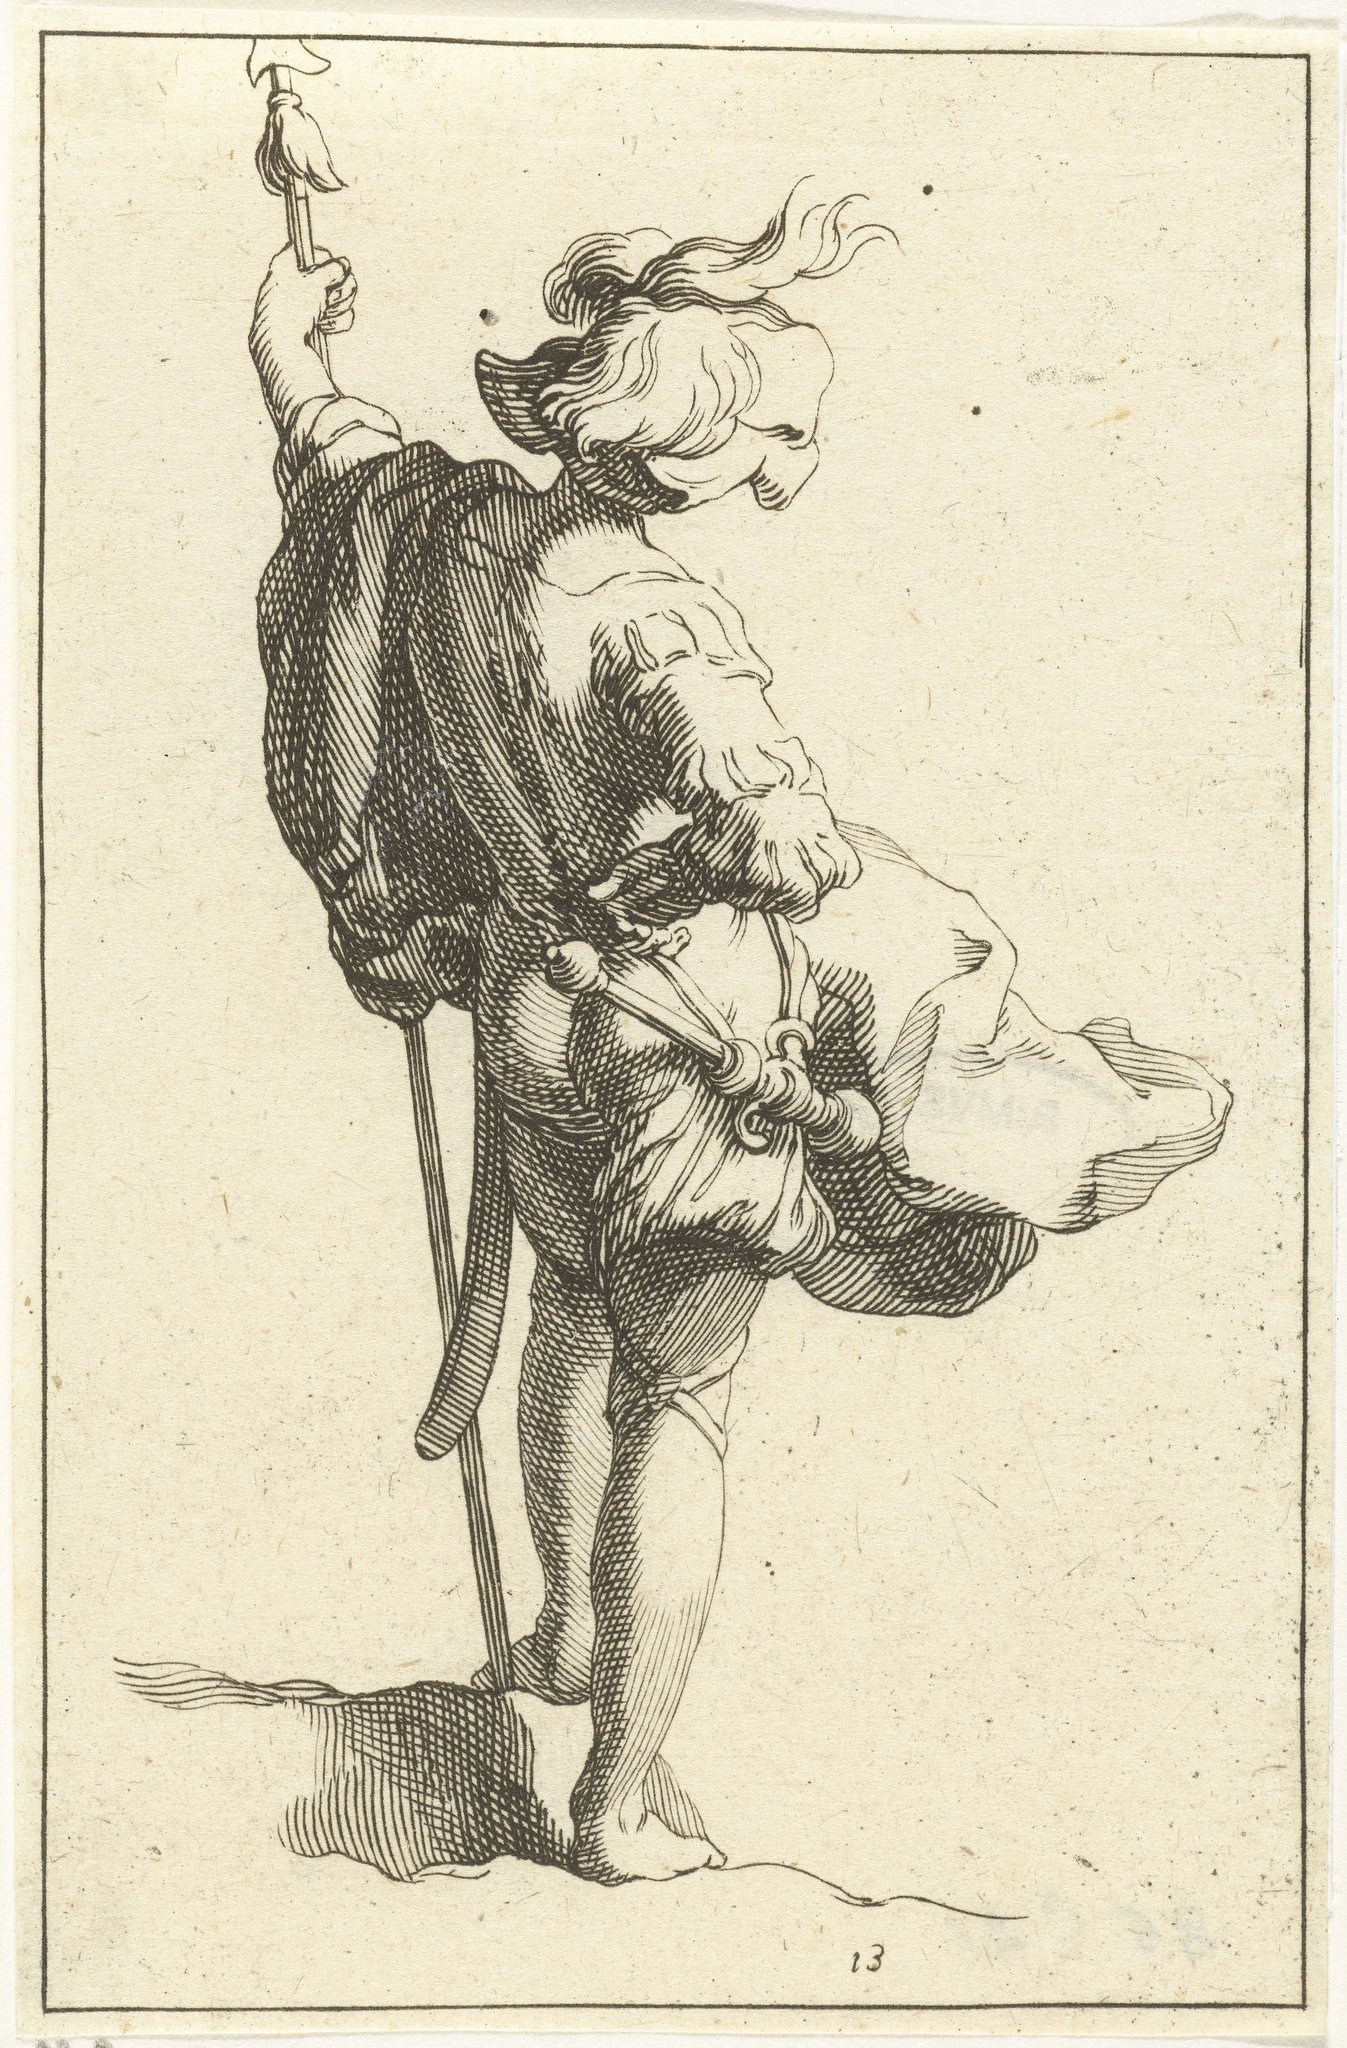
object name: print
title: De kleine figuren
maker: frederick bloemaert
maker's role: print maker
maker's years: 1614-1669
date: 1635-1669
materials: paper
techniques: engraving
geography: utrecht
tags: soldiers and civilians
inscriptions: collector's mark: Lugt 2233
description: Jonge soldaat, op de rug gezien met zijn linkerhand op een speer steunend.